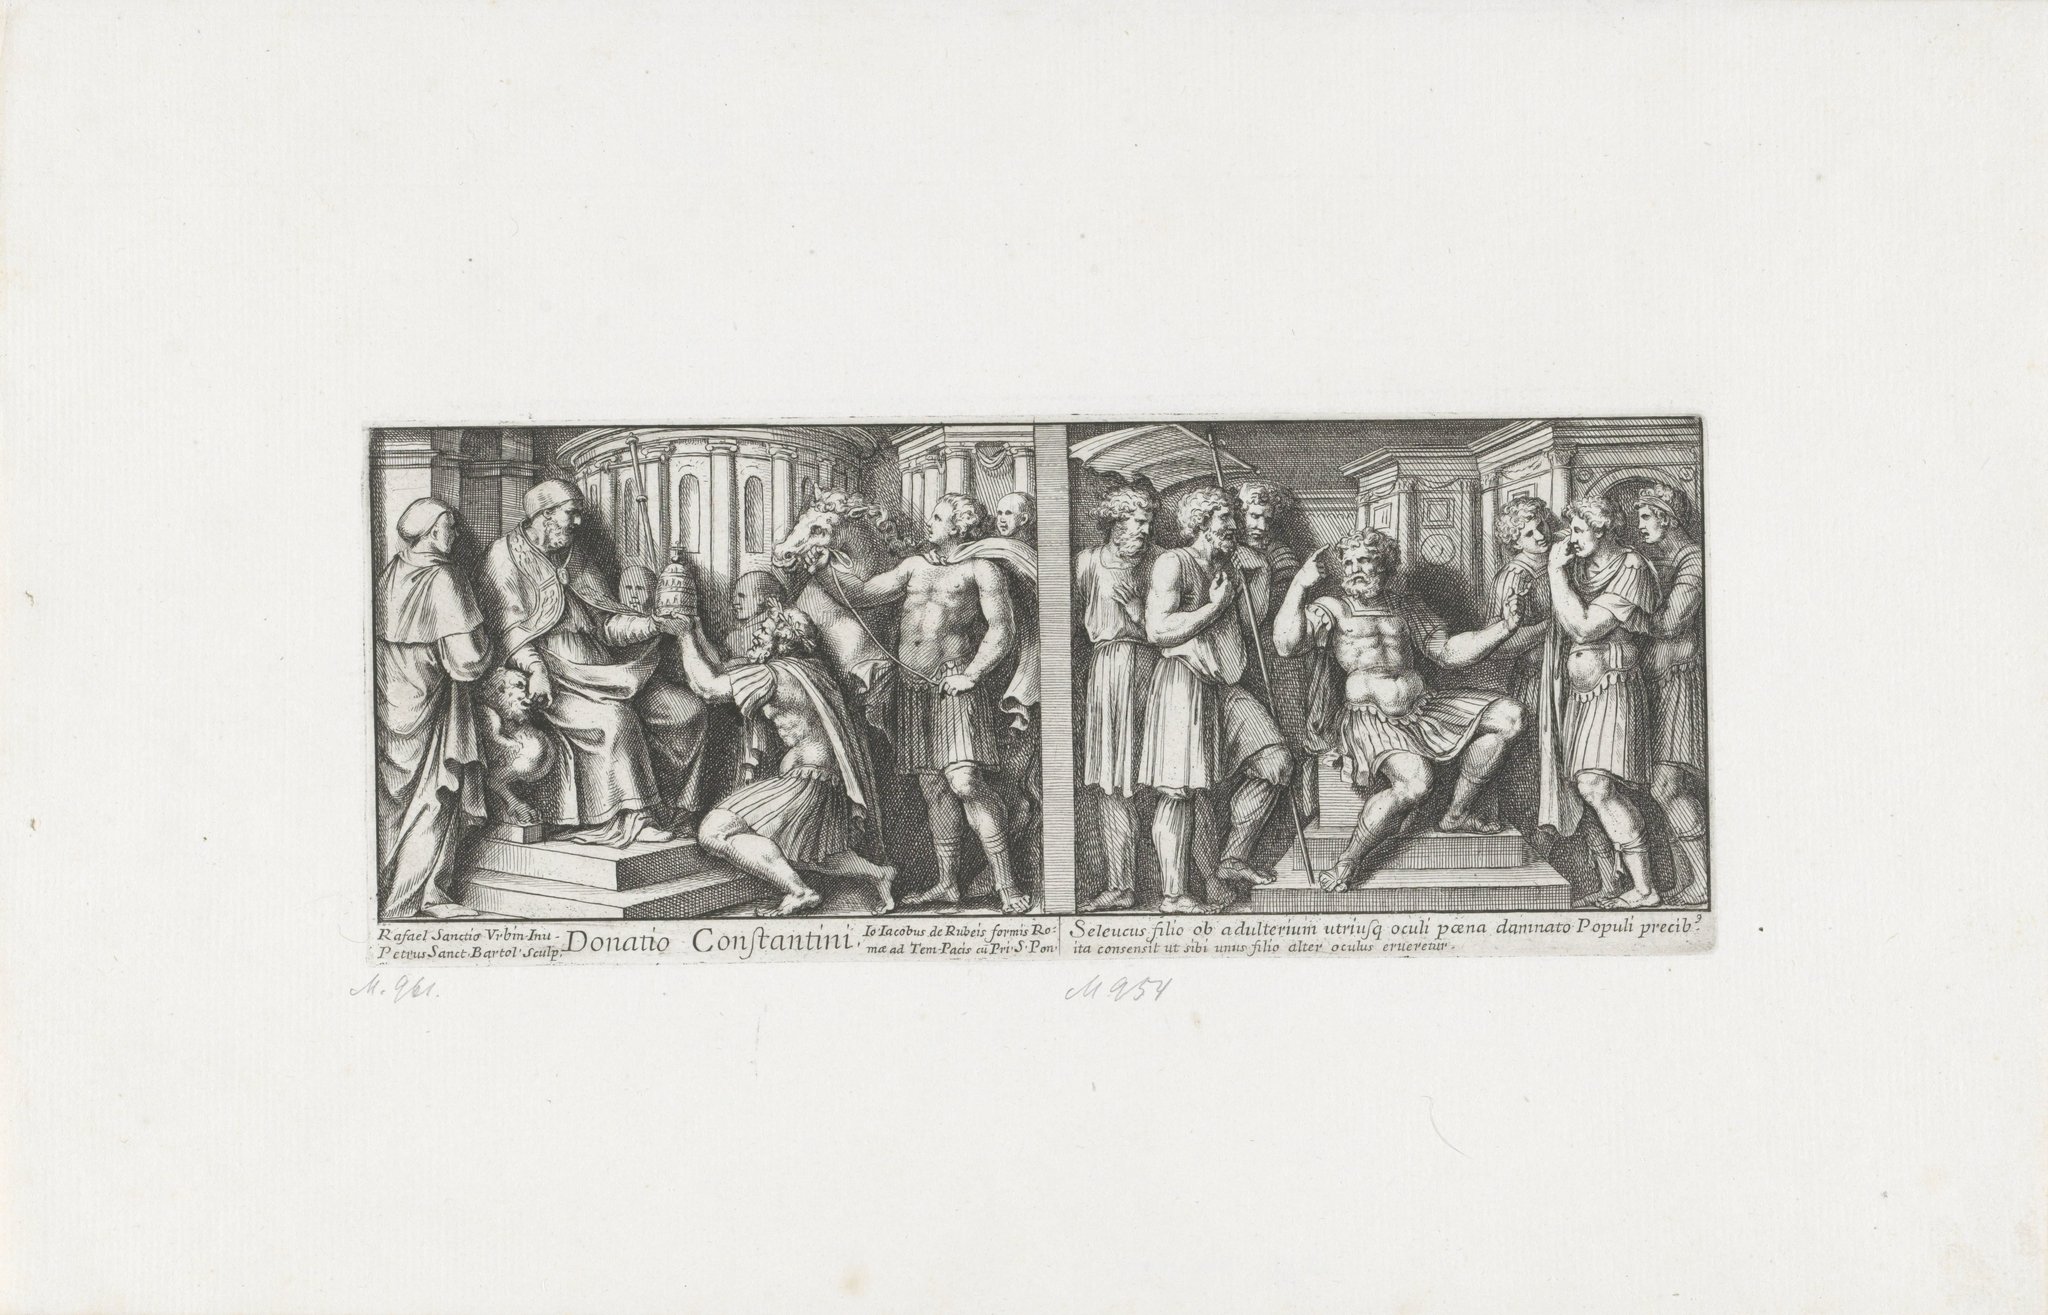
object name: print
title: Voorstellingen door Rafaël in het Vaticaan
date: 1645-1700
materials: paper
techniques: engraving, etching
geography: vatican city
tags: rome, ruler, sovereign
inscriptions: collector's mark: Lugt 2228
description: Prent uit een reeks van 14 prenten (+ titelprent) naar schilderingen door Rafaël in de Stanze di Raffaello in het Apostolisch Paleis in het Vaticaan en naar ontwerpen voor wandtapijten voor de Sixtijnse Kapel door Rafaël. Linker voorstelling naar een schildering door Rafaël in de Stanza di Eliodoro. Rechter voorstelling naar een schildering door Rafaël in de Stanza della Segnatura.